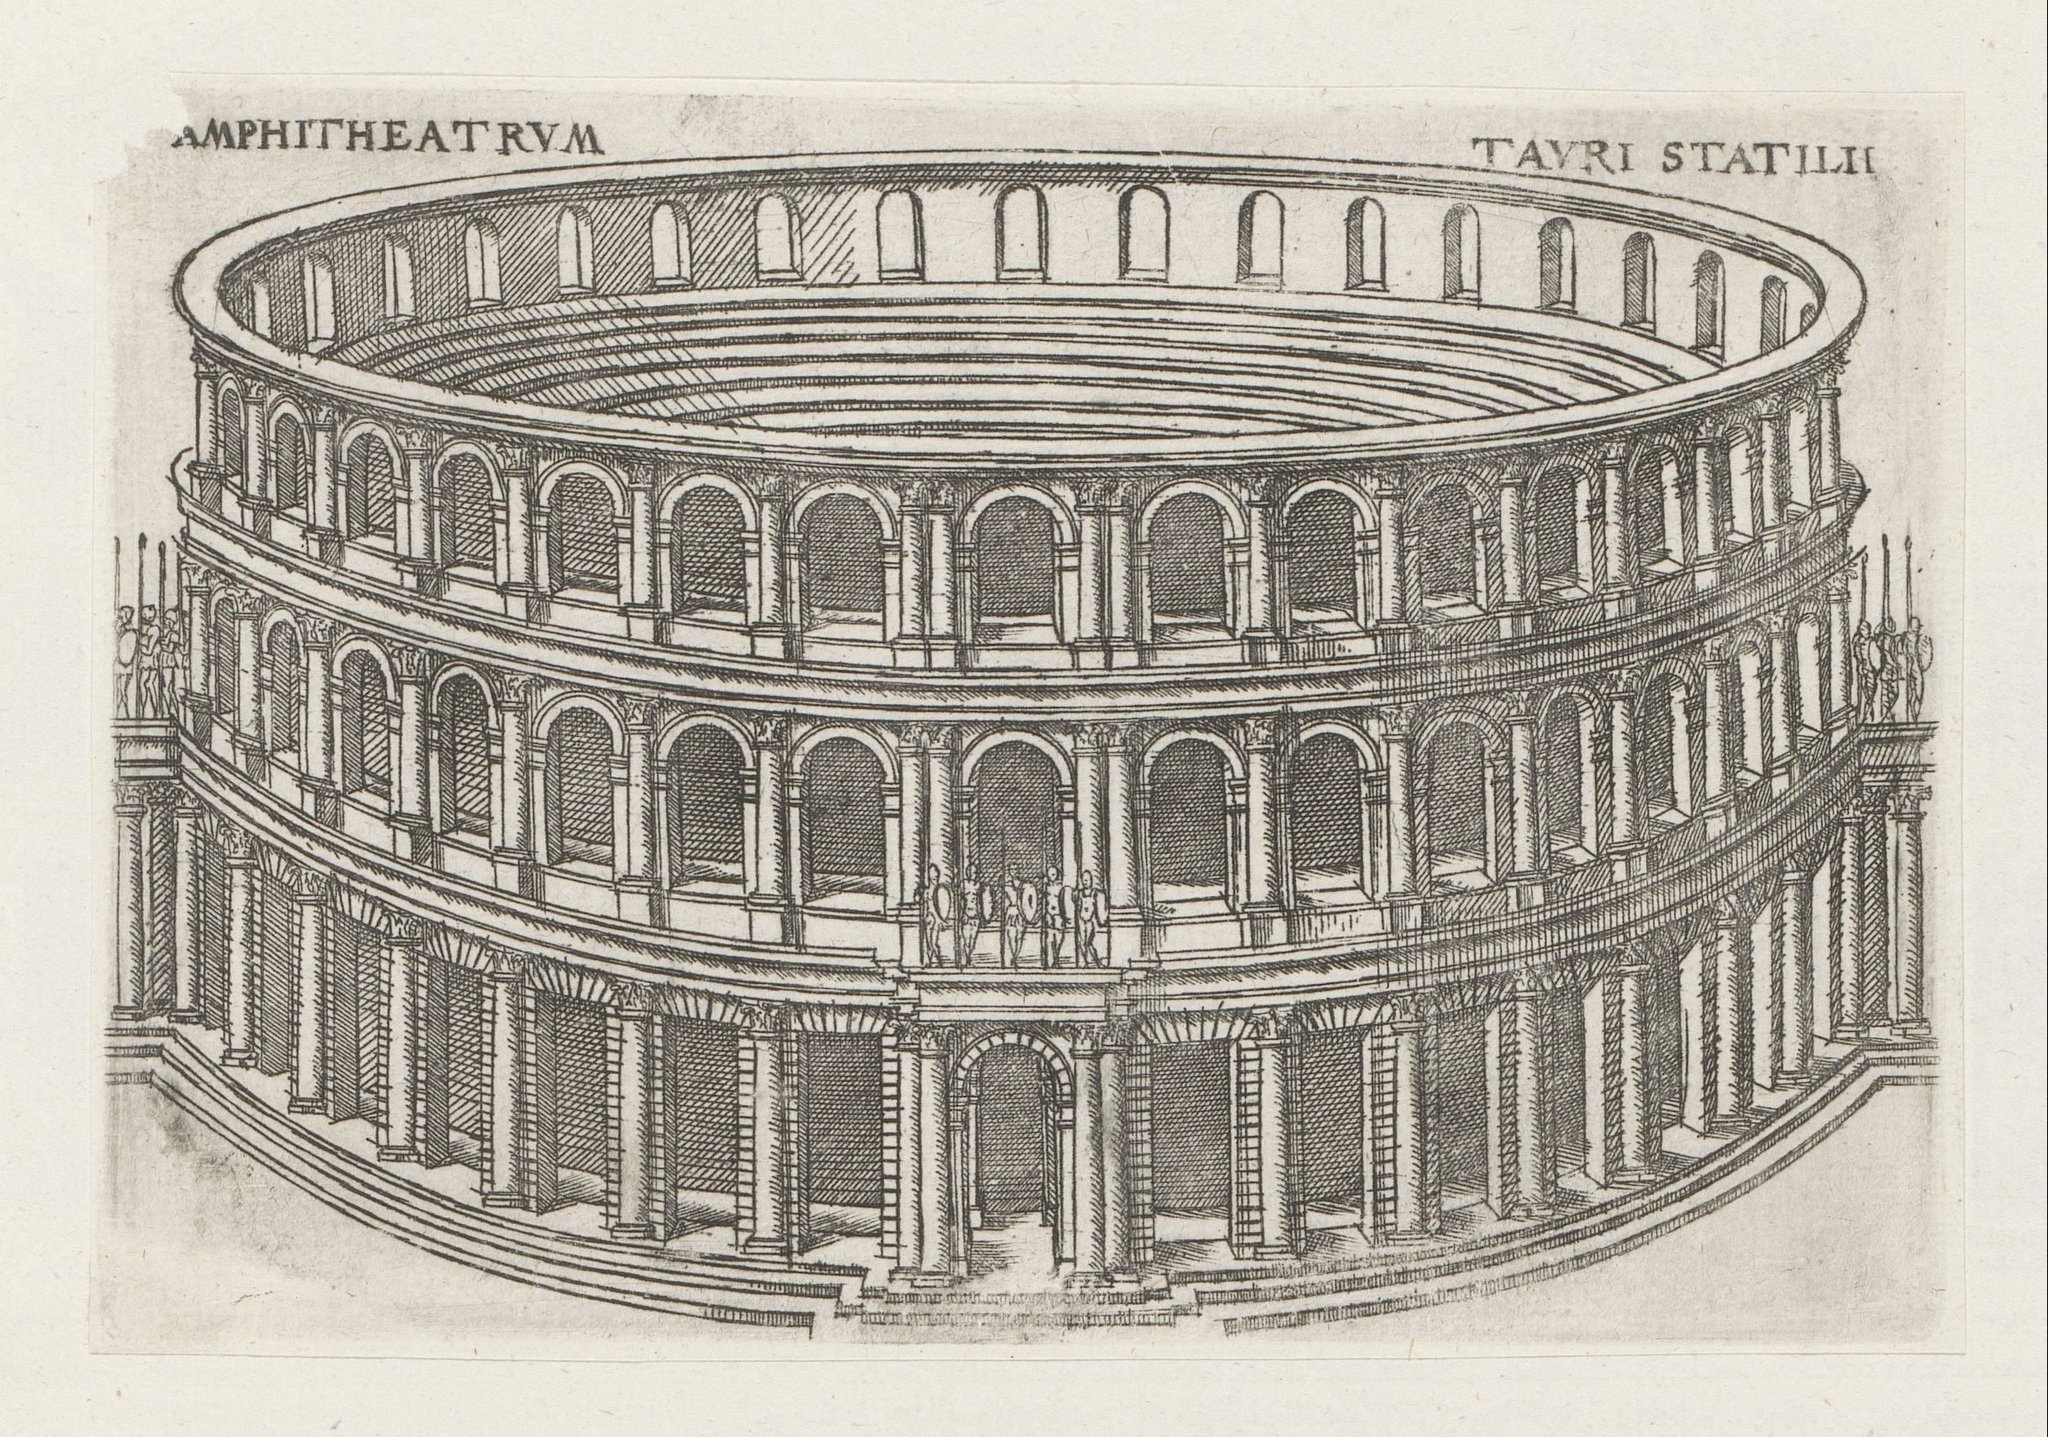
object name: album leaf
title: Het Amfitheater van Statilius Taurus te Rome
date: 1584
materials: paper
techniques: etching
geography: france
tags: theatre (building) - aa - open-air performances, representation of real building (either existing or having existed)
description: Deze prent maakt deel uit van een serie van 98 prenten gedrukt op 48 bladen. De bladen zijn verknipt en een selectie van de losse prenten is in dit album geplakt.